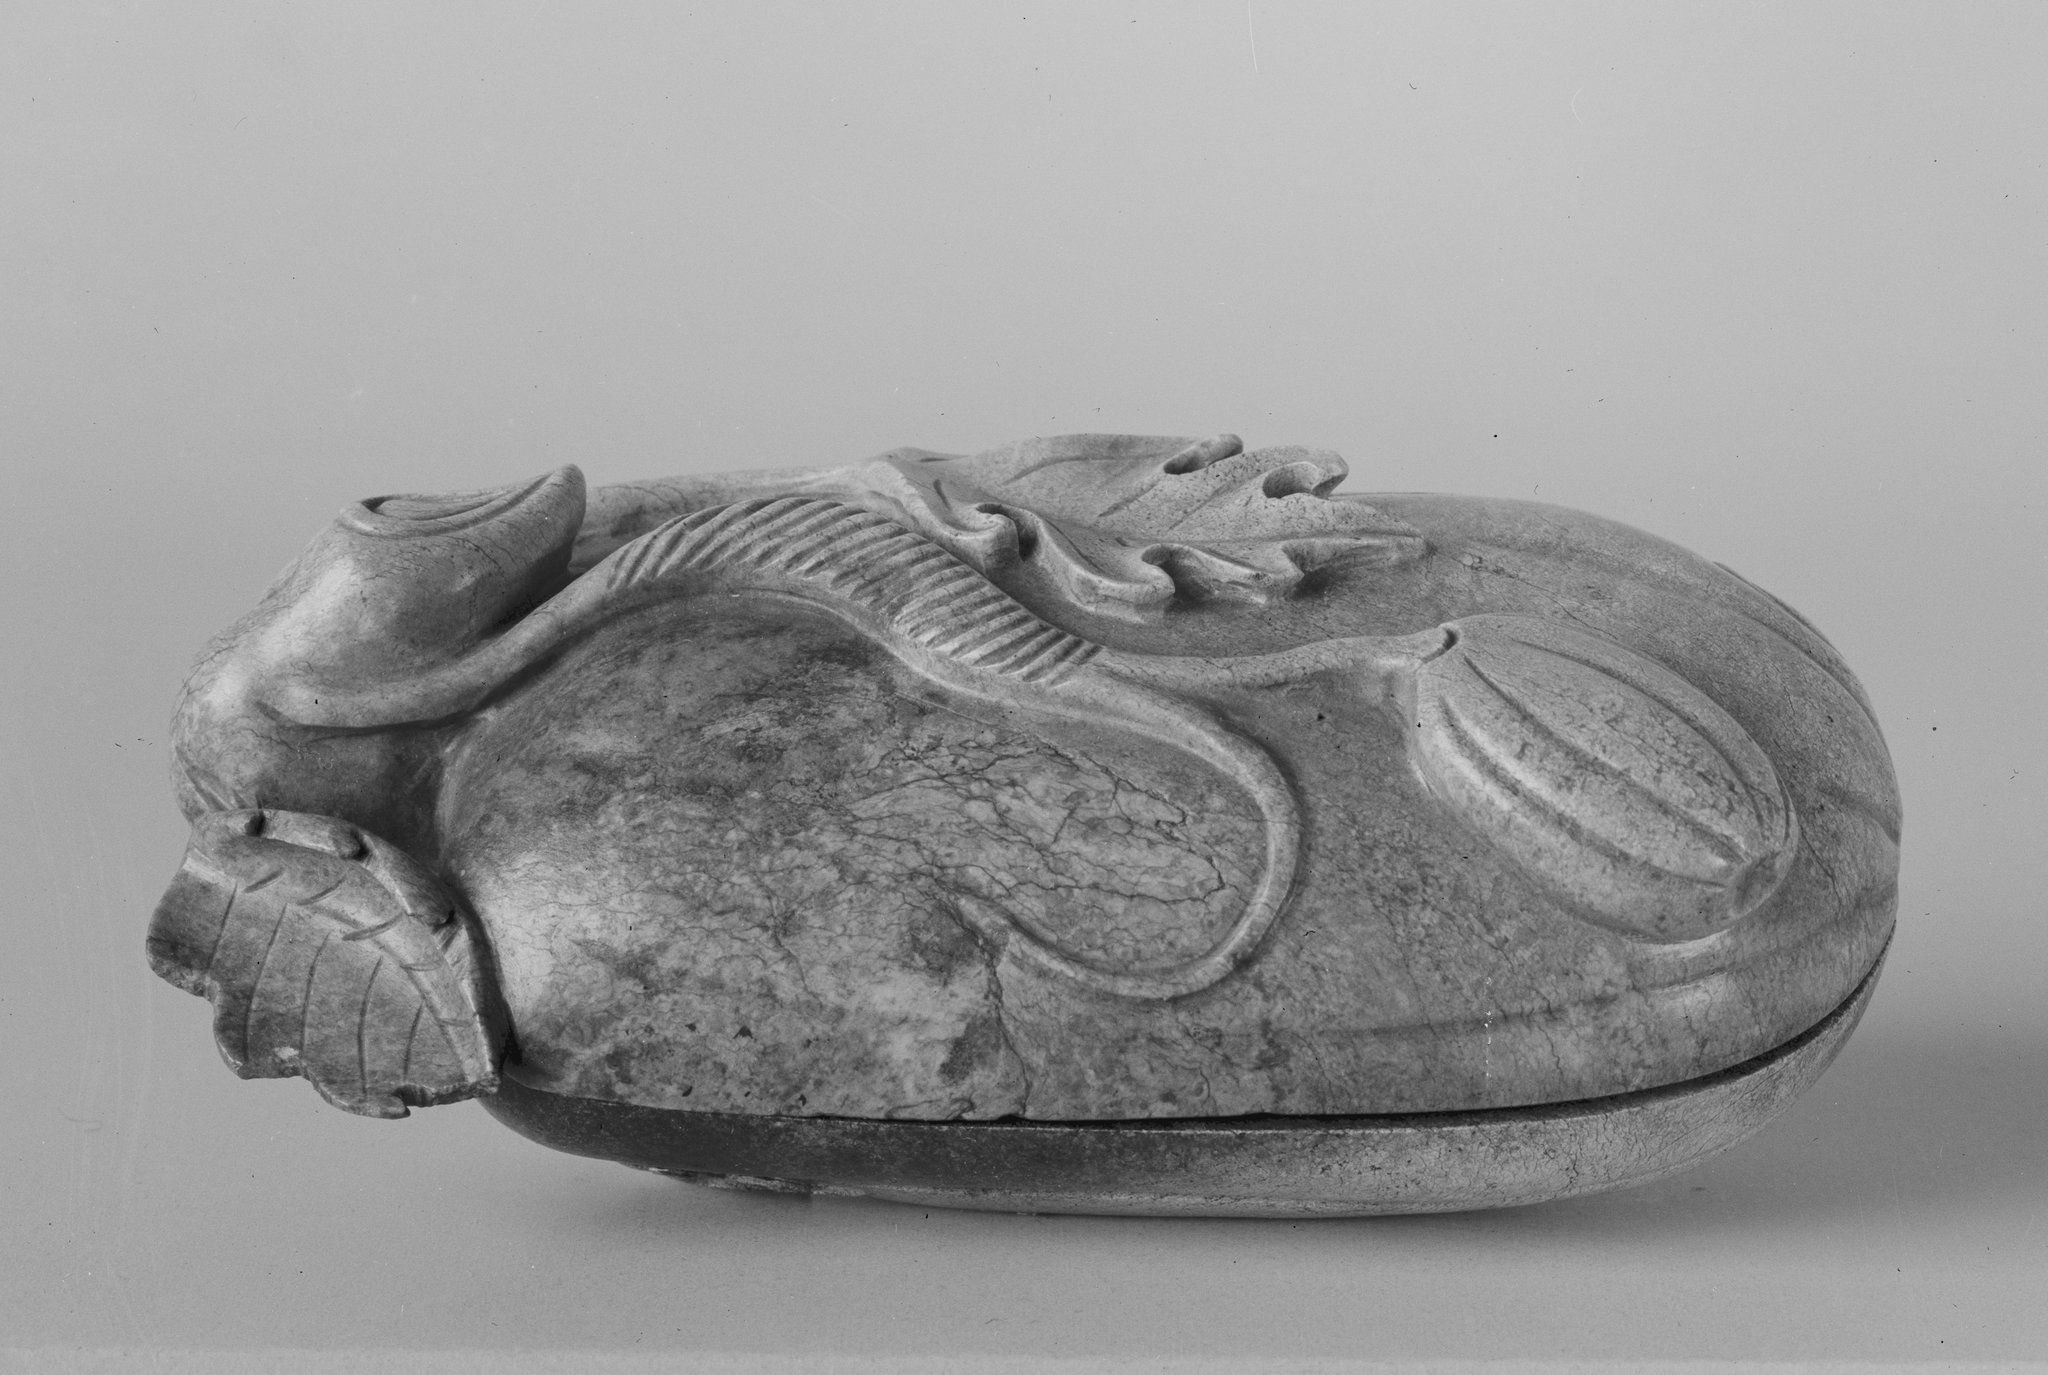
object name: box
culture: chinese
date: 1701-1800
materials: jade